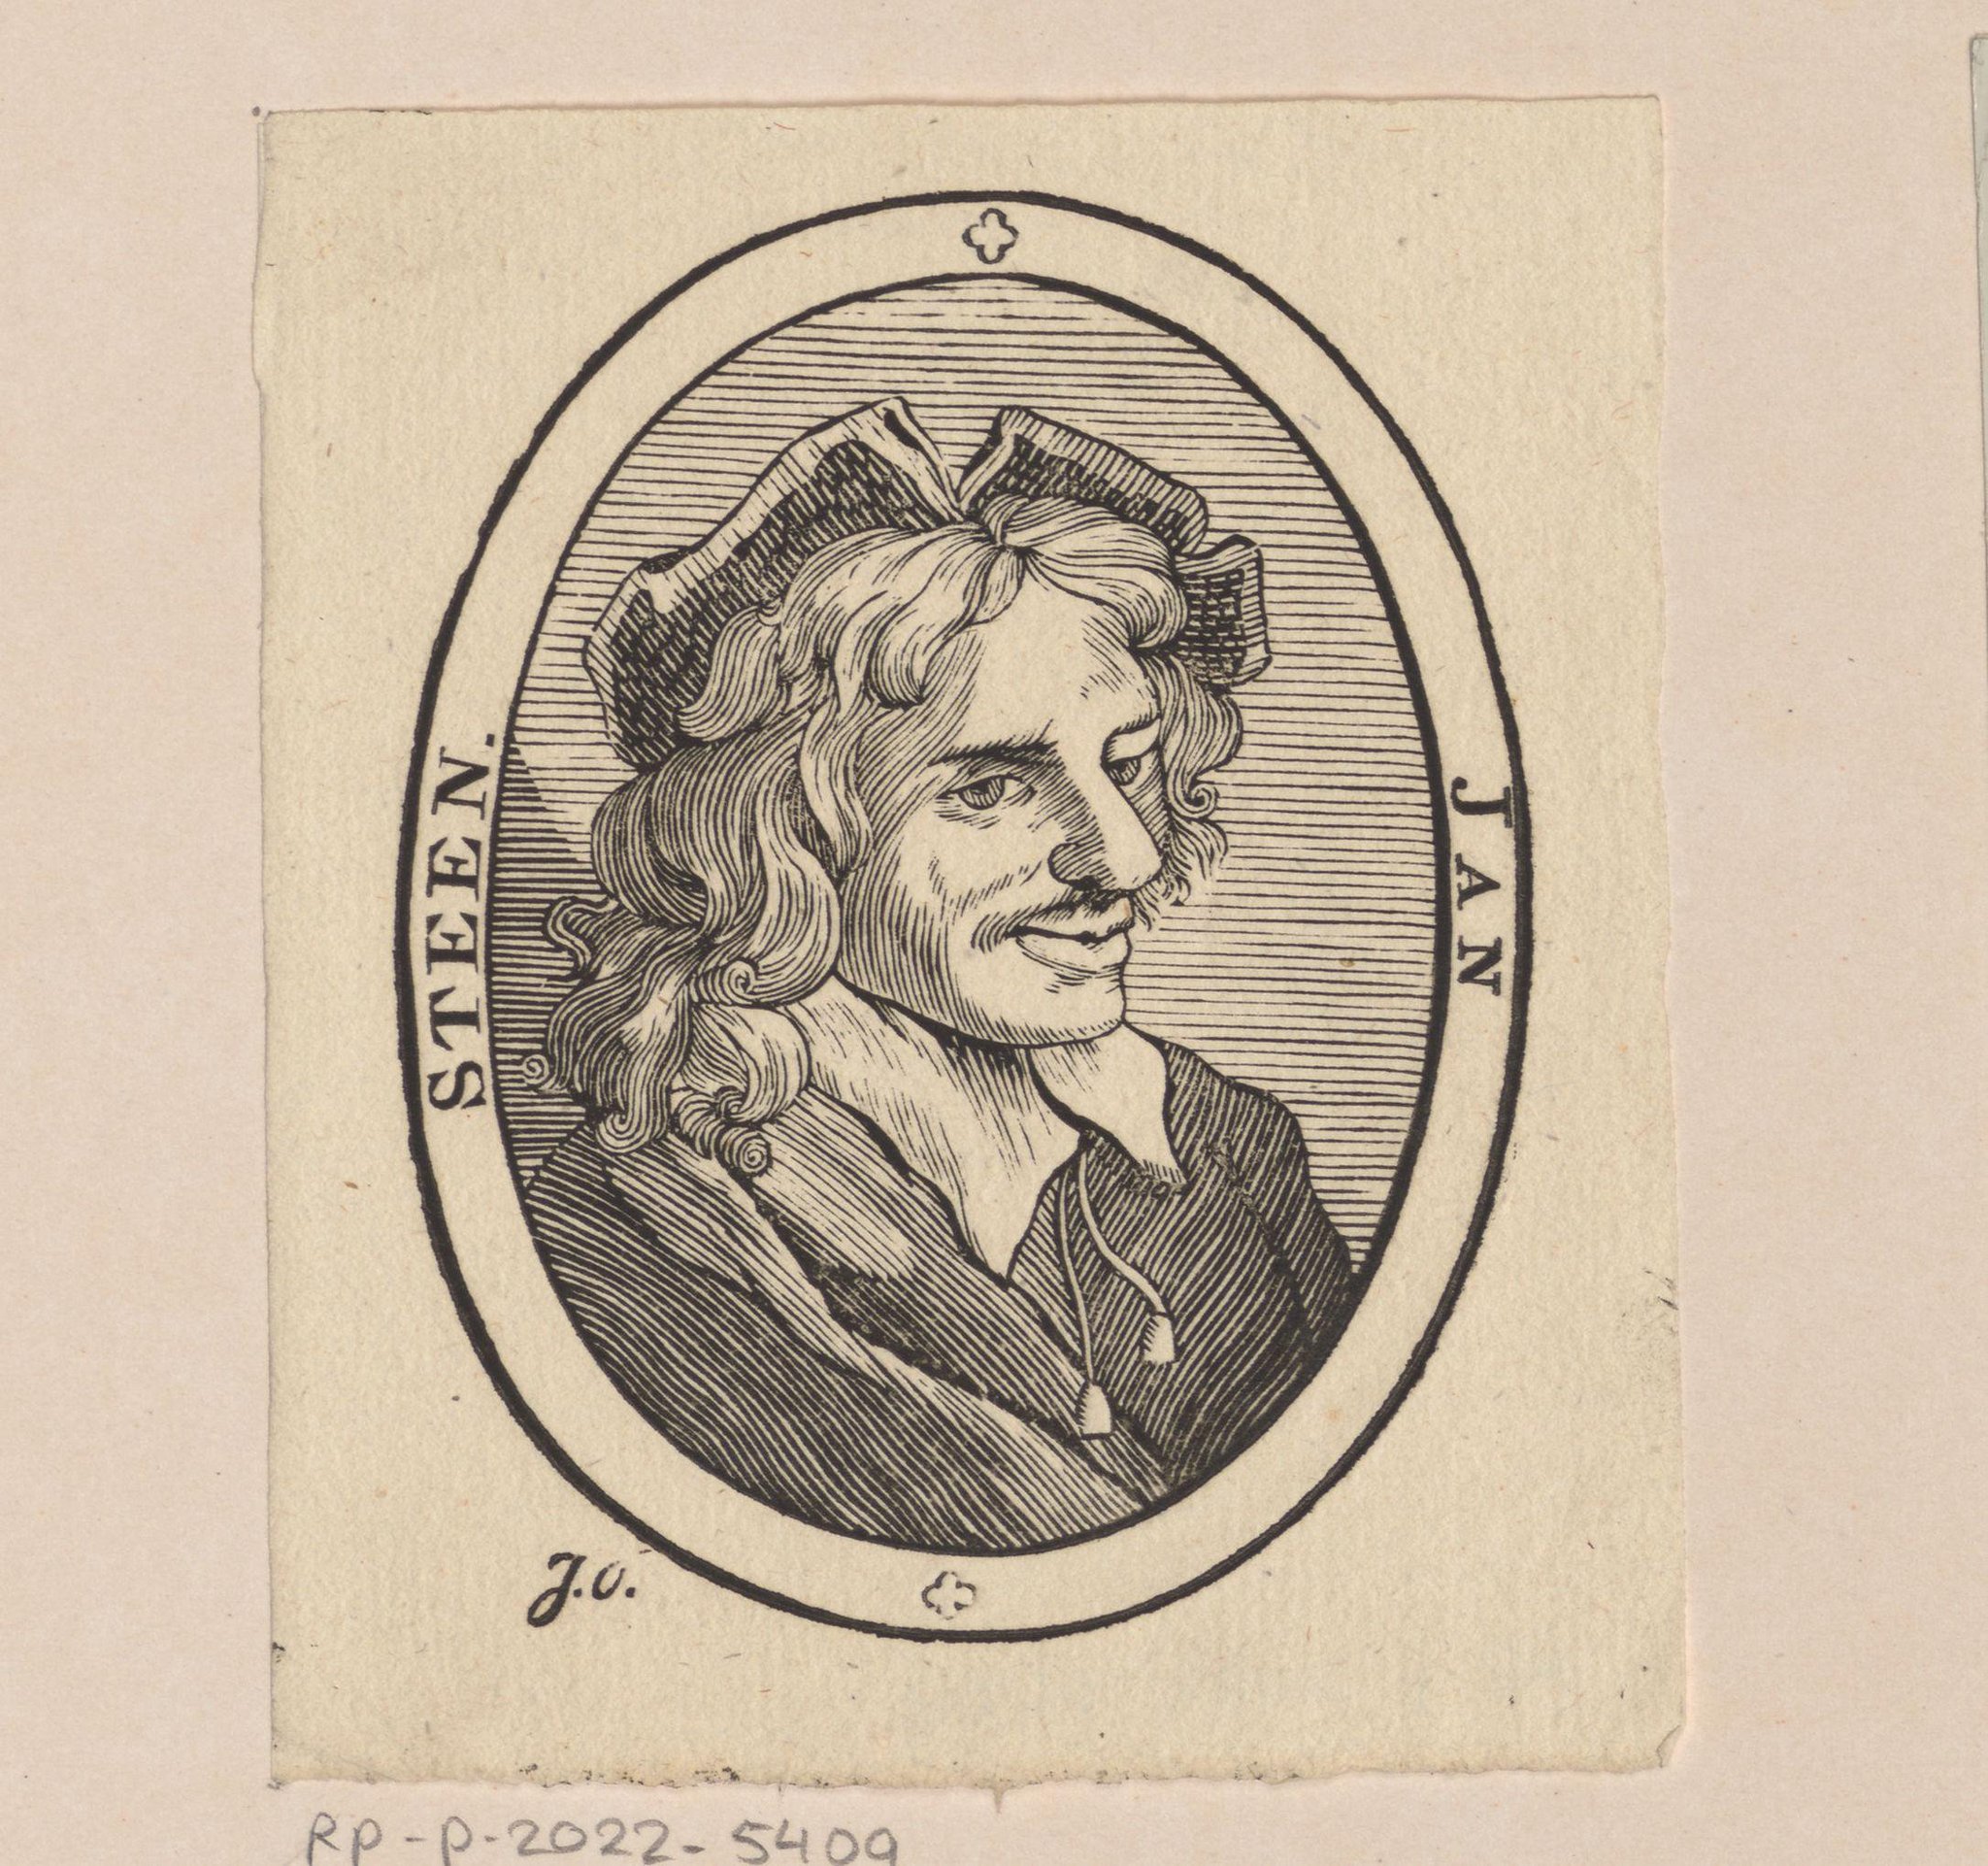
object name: print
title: Portret van Jan Havicksz. Steen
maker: jan oortman (sr.)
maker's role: print maker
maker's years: 1753-1823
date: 1763-1823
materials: paper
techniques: woodcut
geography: netherlands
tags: leiden, painter, print maker, jan havicksz. steen, historical persons, portrait, self-portrait of artist